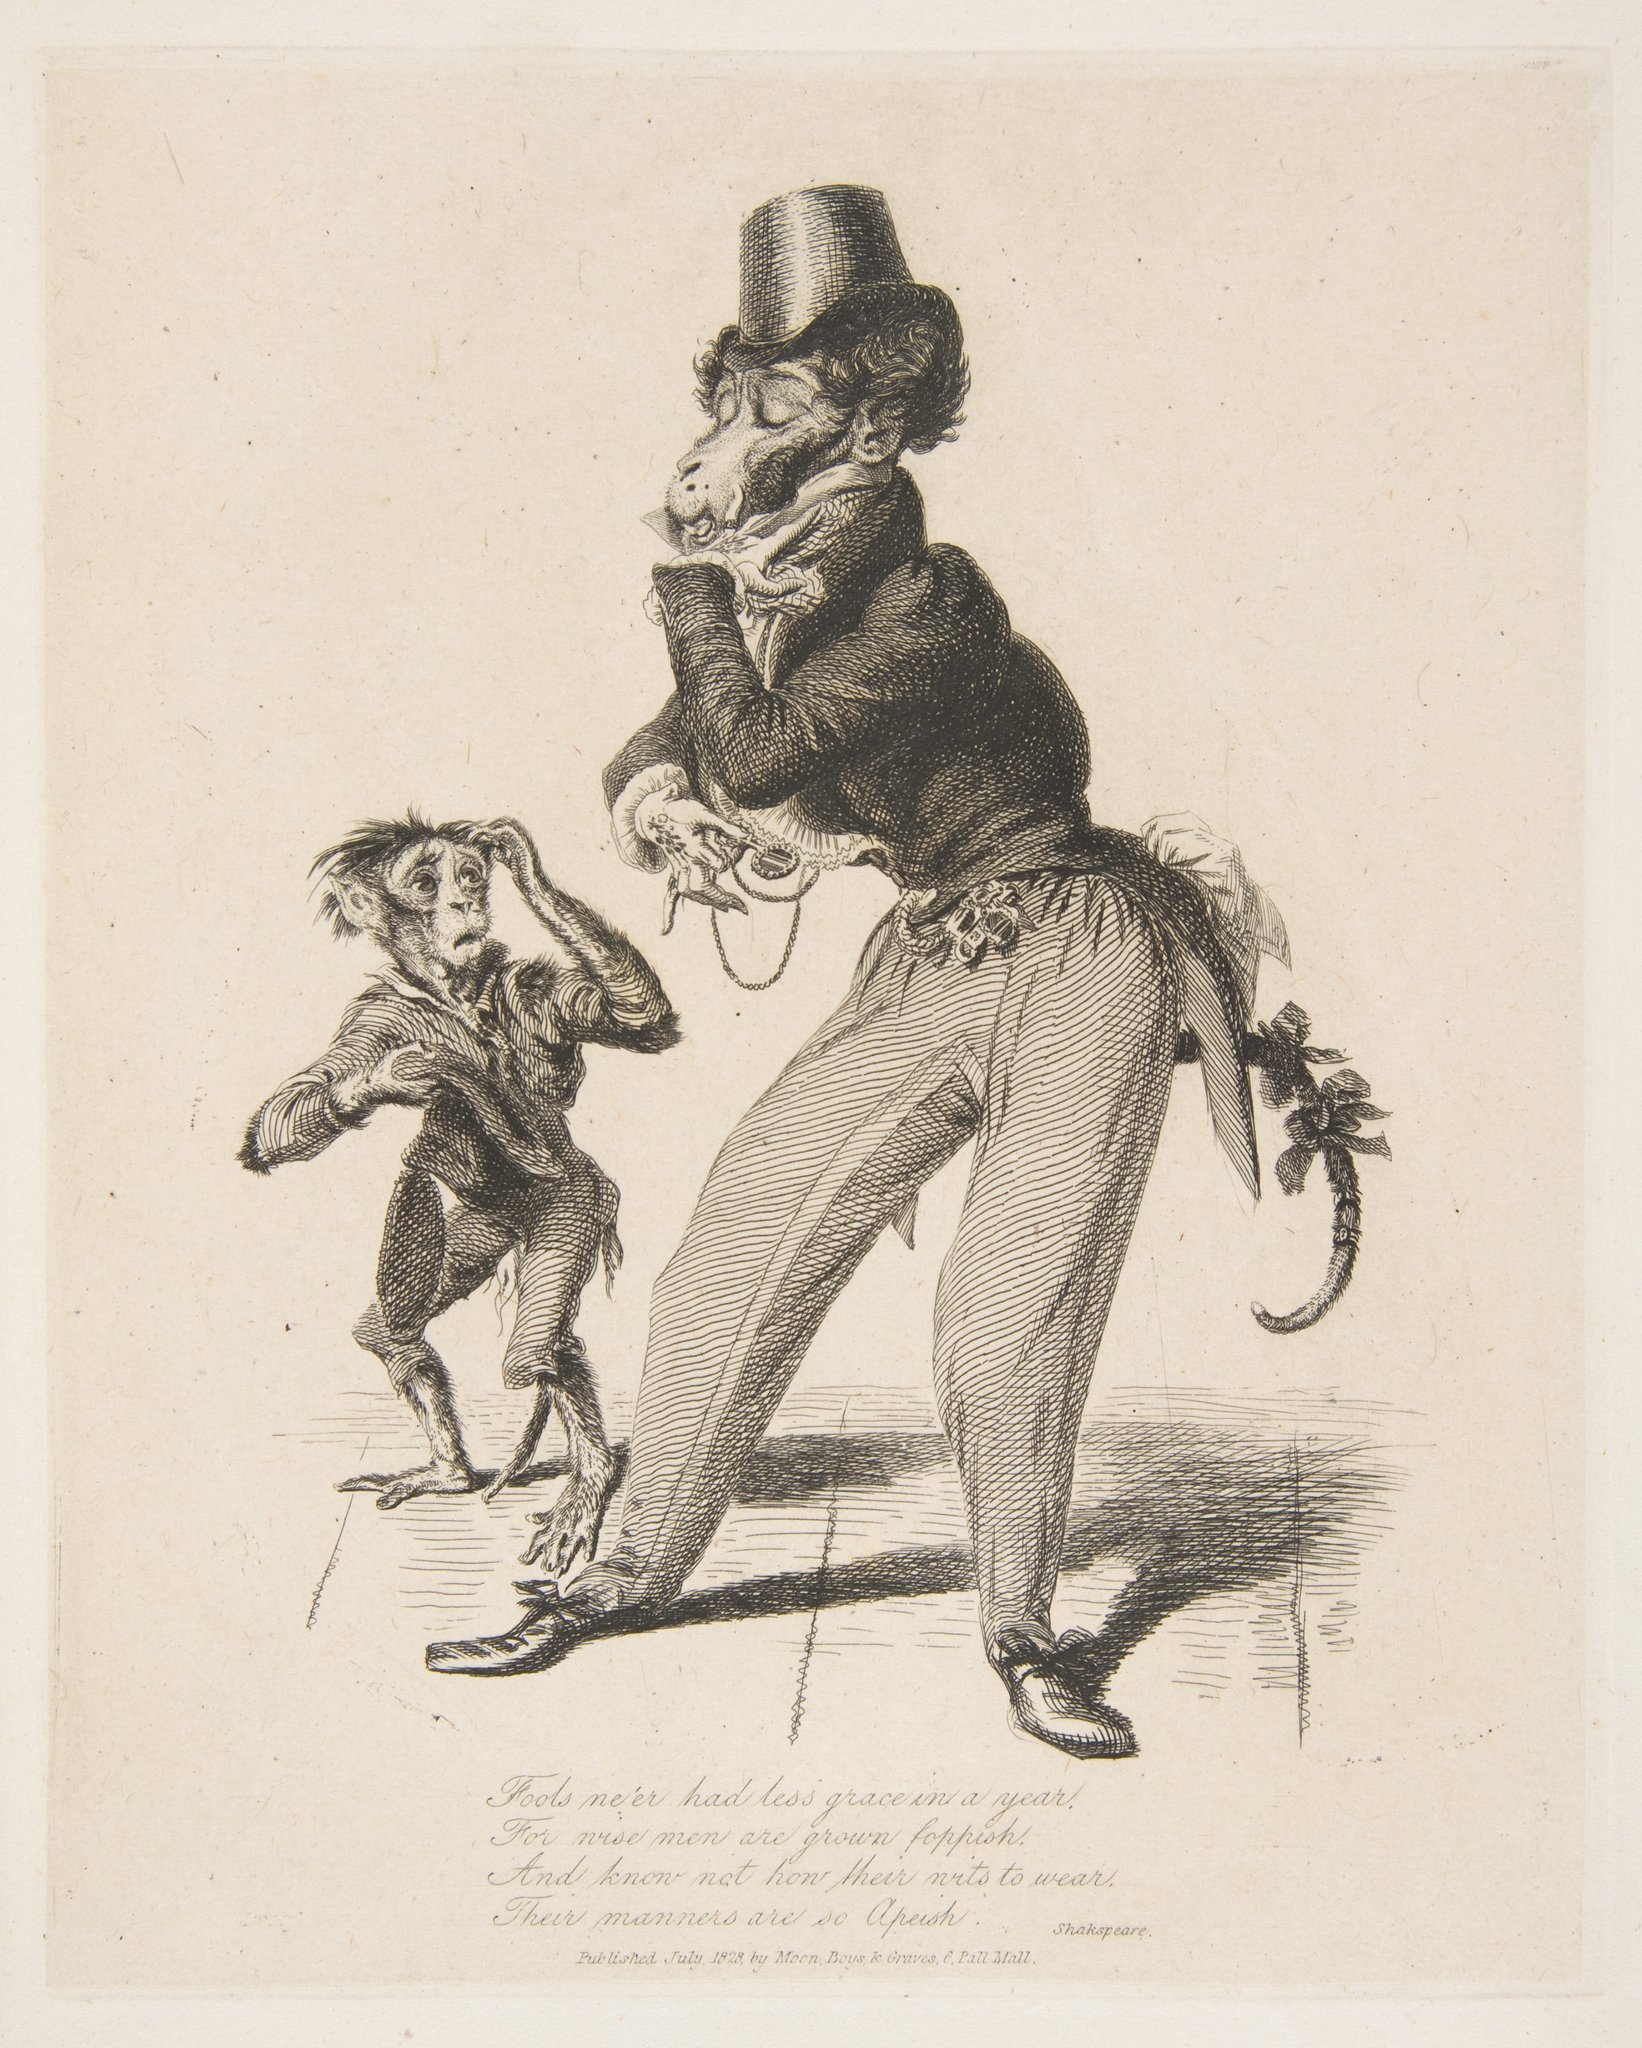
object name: print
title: Monkey Dandy, from Monkey-ana, or Men in Miniature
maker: thomas landseer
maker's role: artist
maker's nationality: british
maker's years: 1795-1880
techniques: printmaking, etching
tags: monkeys